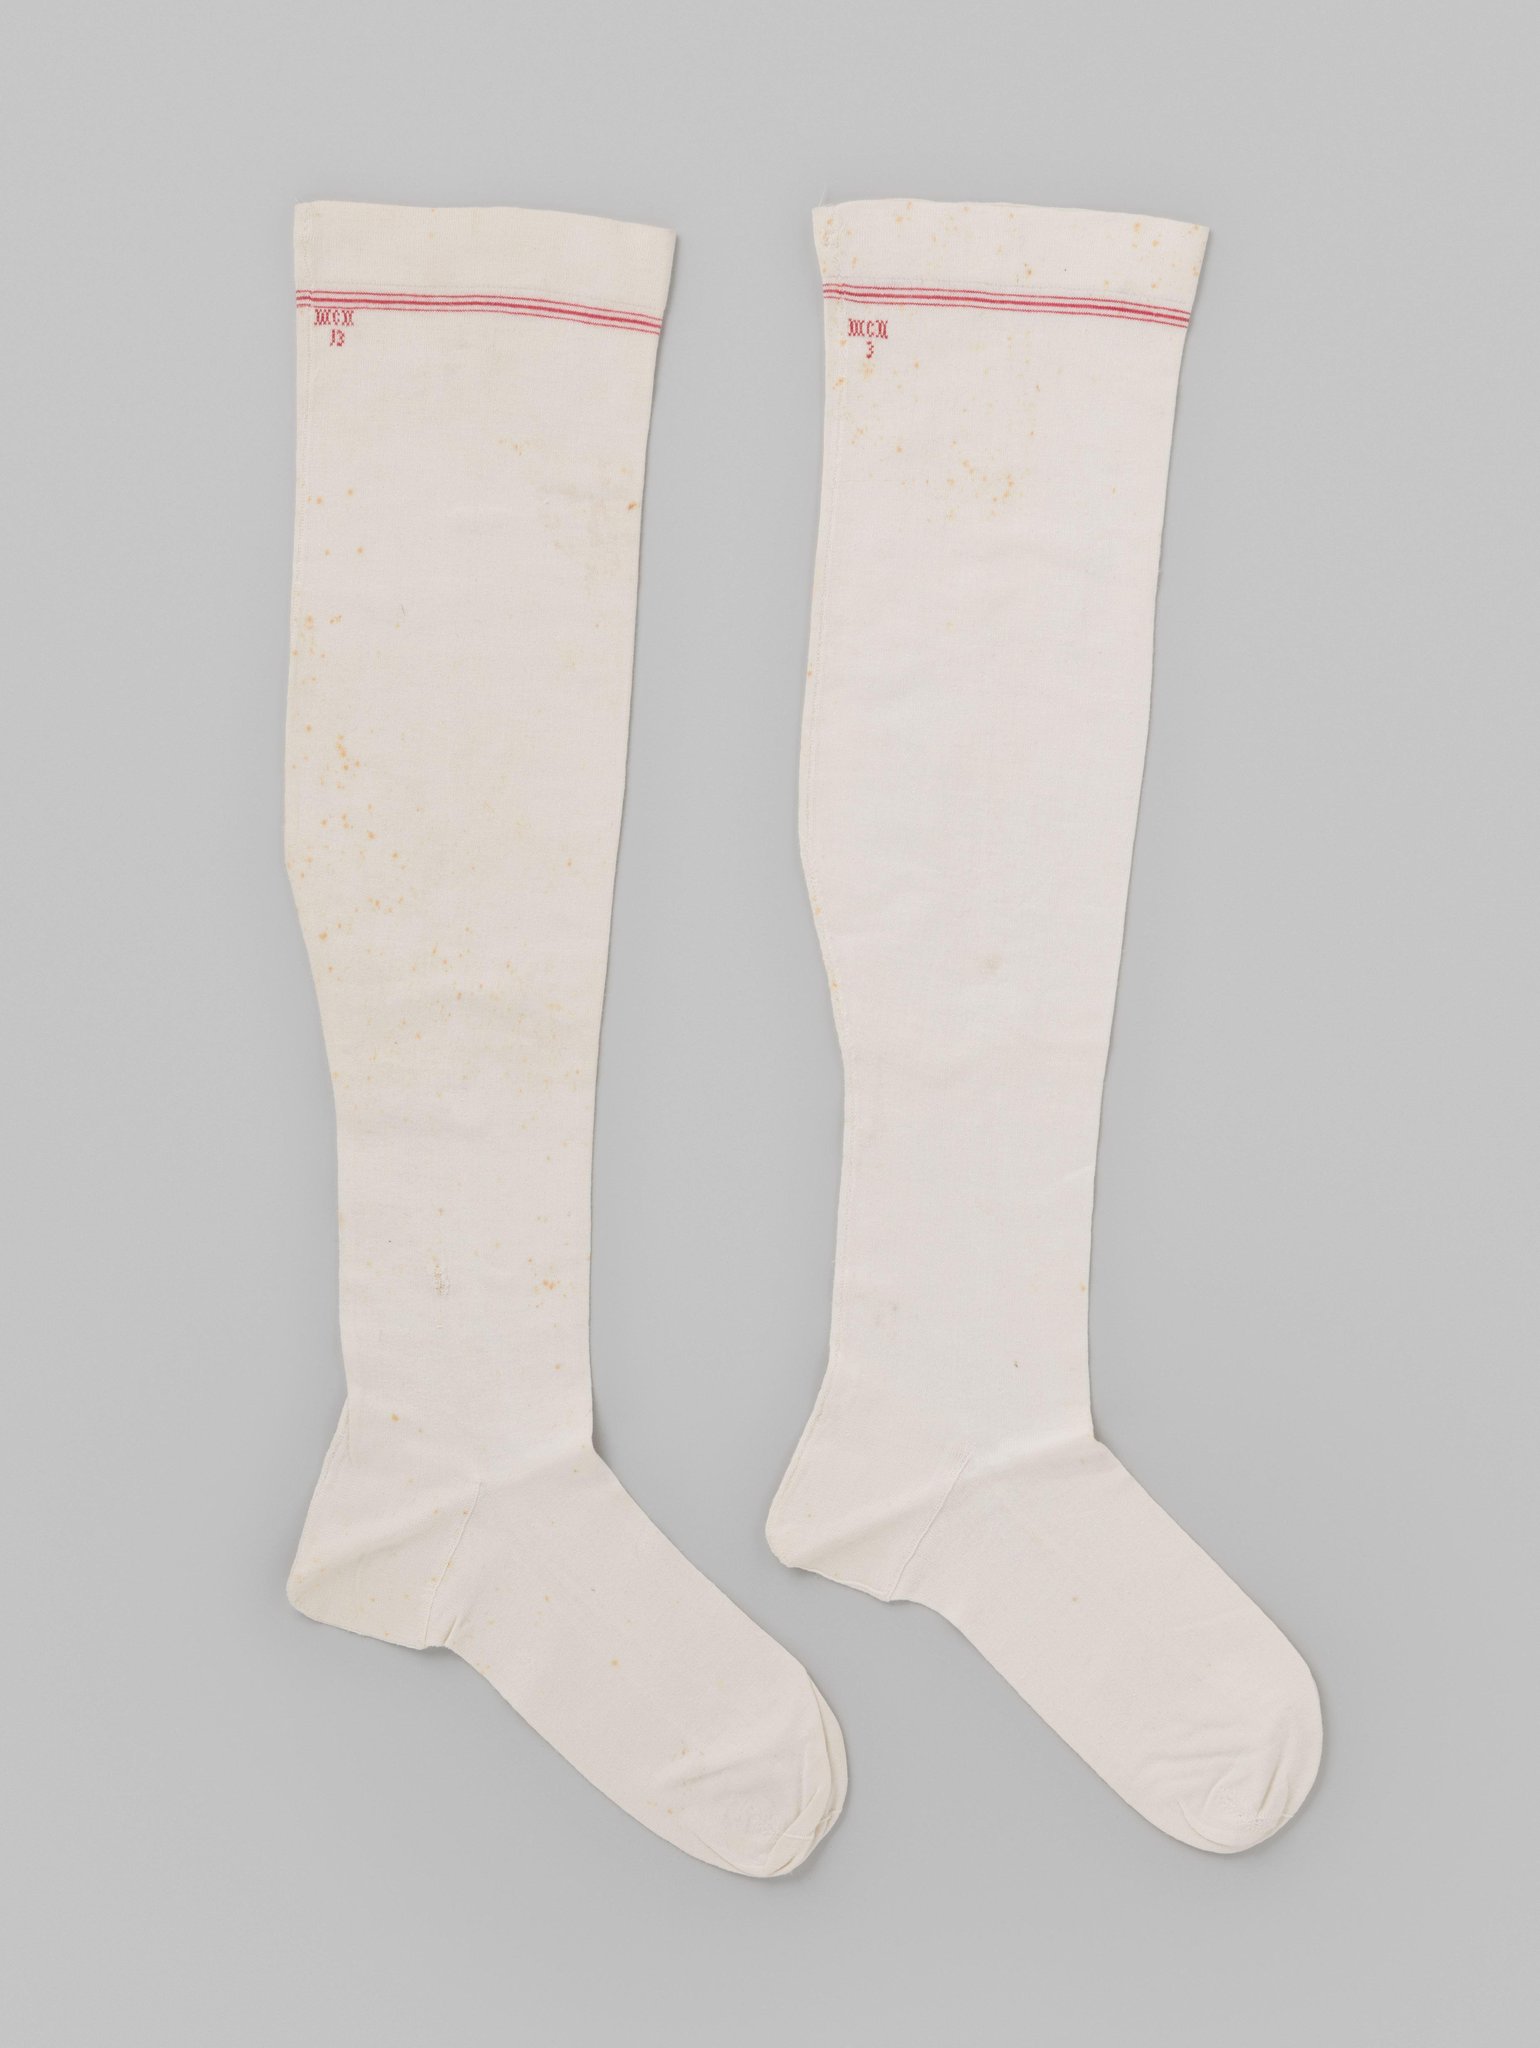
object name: stocking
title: Kous van fijne effen witte katoenen tricot met drie smalle streepjes onder de boord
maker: Anonymous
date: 1835-1865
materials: cotton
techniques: cross stitching, embroidered, knitting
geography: netherlands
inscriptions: inscription: ‘'MCN 3'’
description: Kous van fijne effen witte katoenen tricot met drie smalle rode streepjes onder de boord. Naad middenachter. In rood onder de boord in kruissteek: 'MCN 3'.